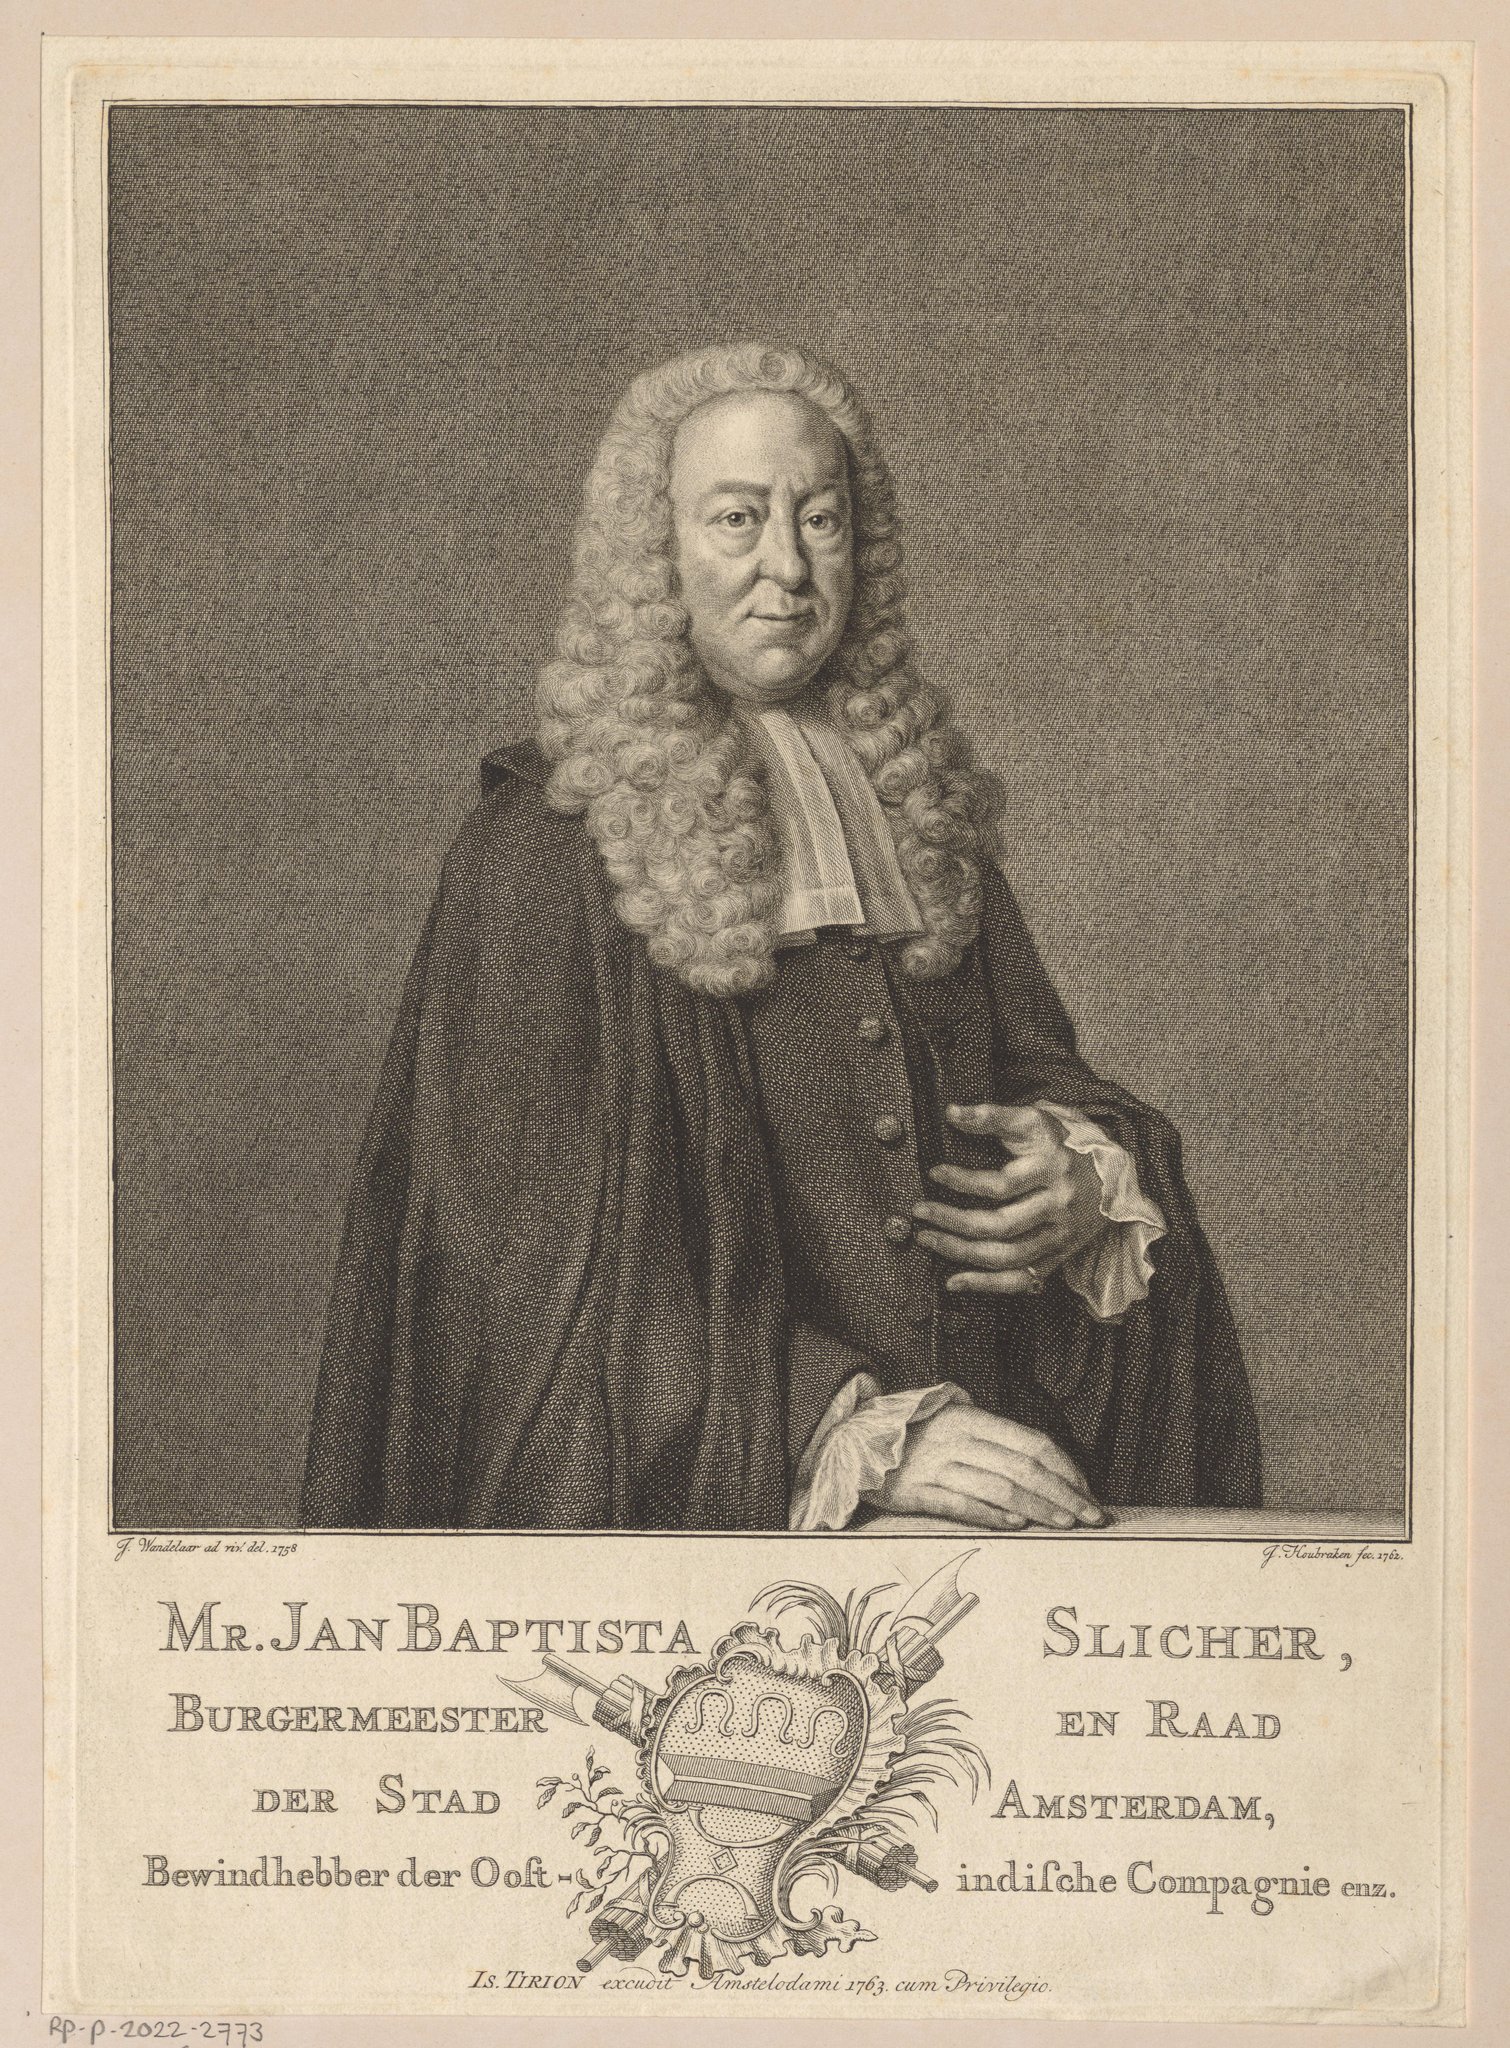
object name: print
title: Portret van Jan Baptista Slicher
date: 1763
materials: paper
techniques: engraving, etching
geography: amsterdam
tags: mayor, burgomaster, historical persons, armorial bearing, heraldry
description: Met vierregelig onderschrift in twee kolommen in het Nederlands.